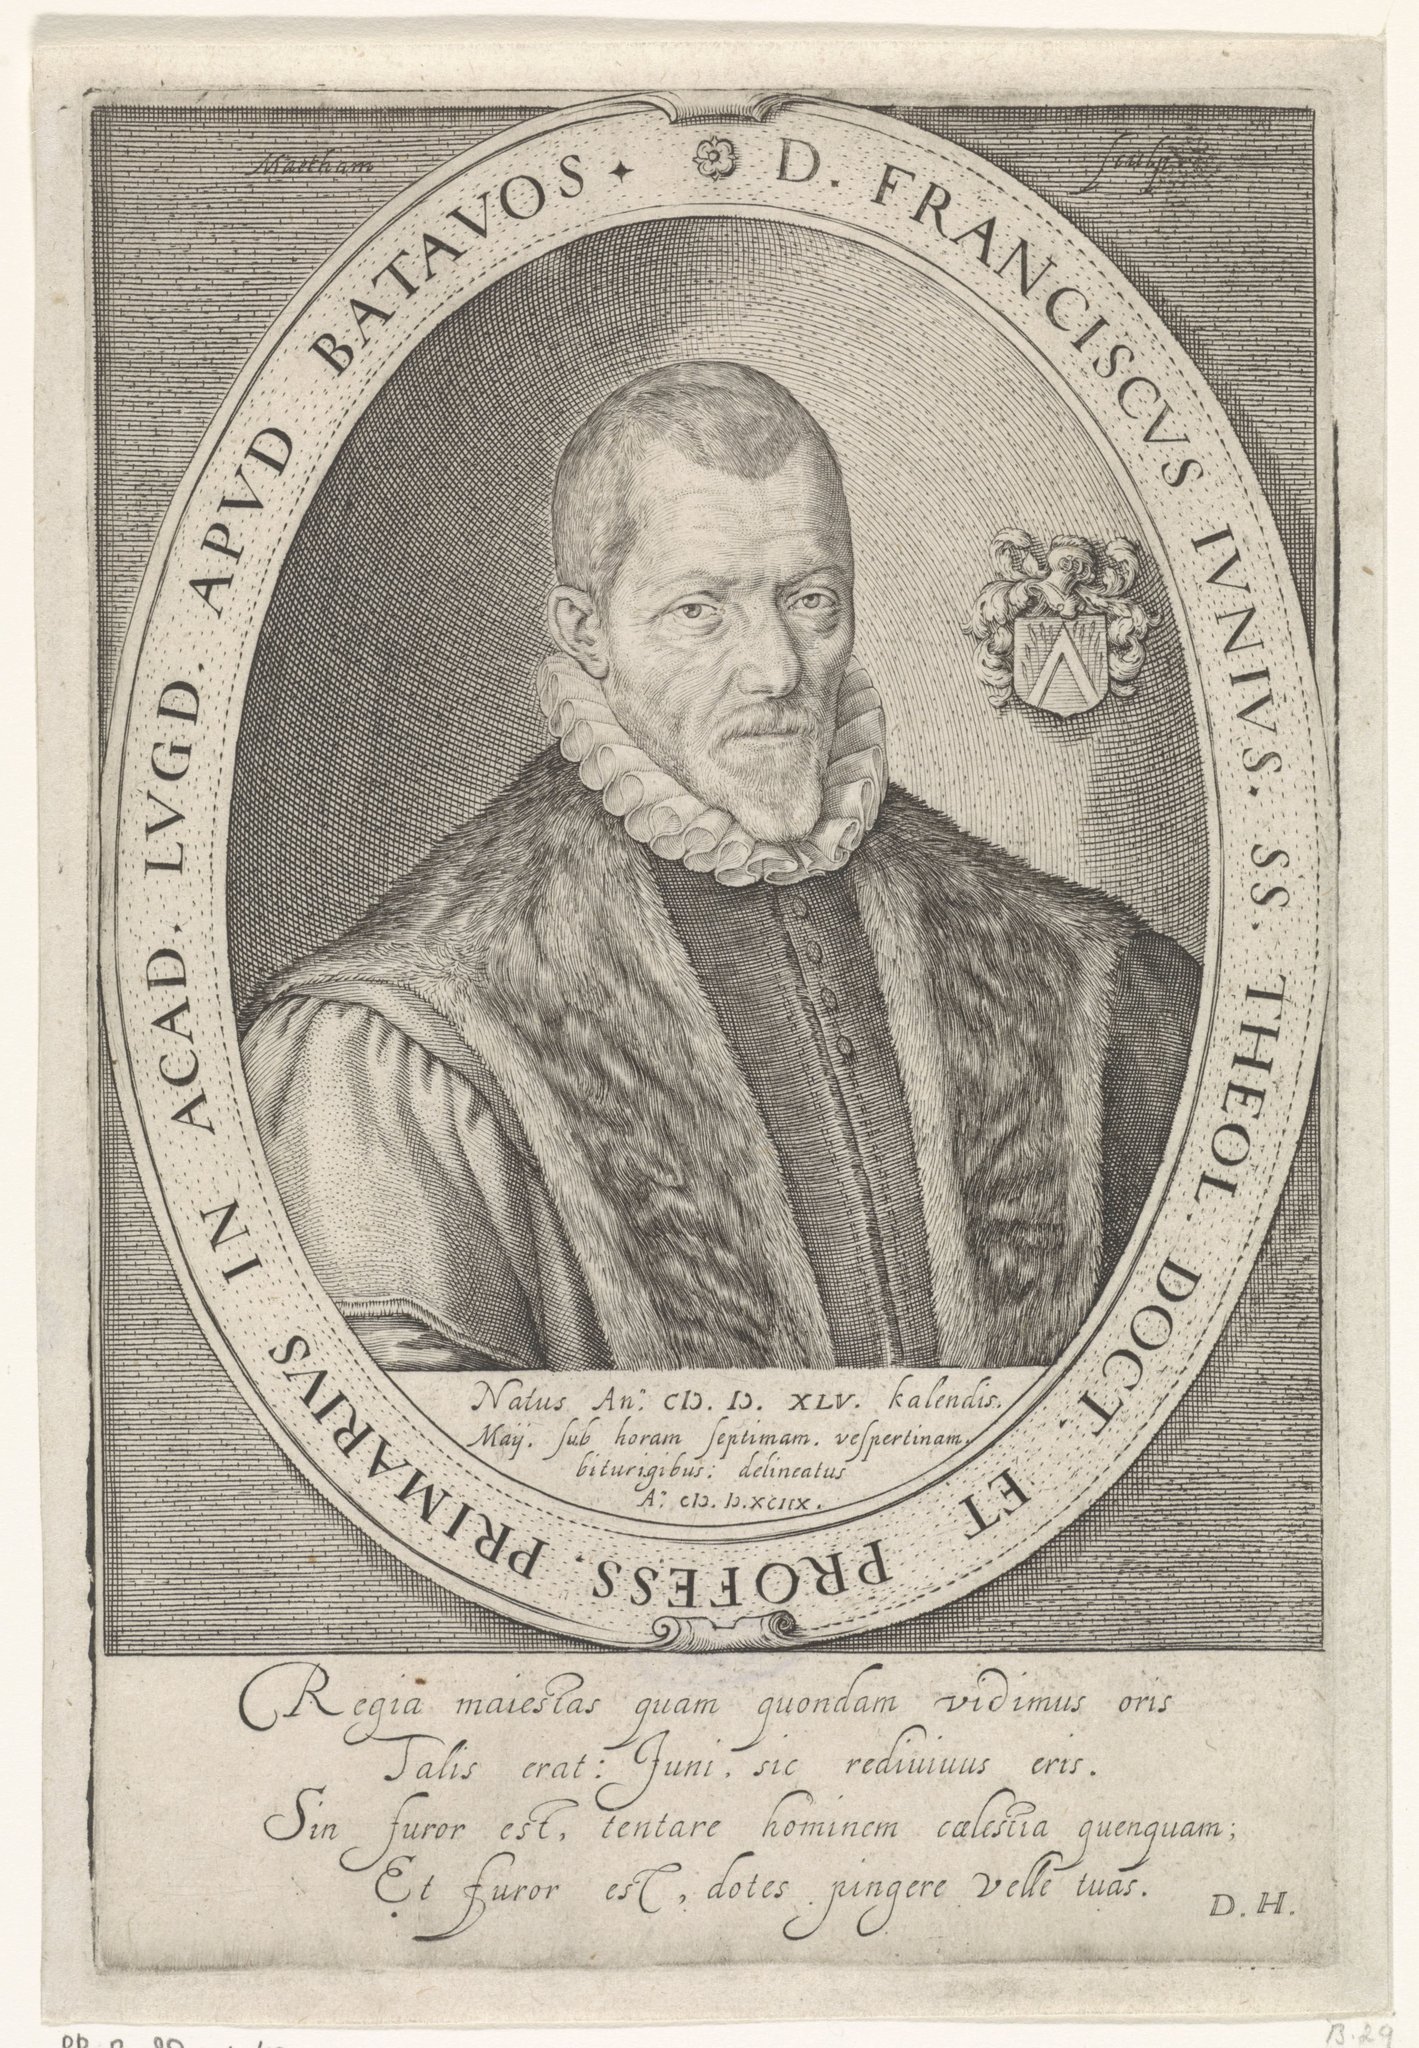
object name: print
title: Portret van Franciscus Junius II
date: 1598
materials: paper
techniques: engraving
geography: haarlem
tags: philology (+ portrait of scholar, scientist), historical persons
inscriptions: collector's mark: Lugt 2228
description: Portret van de taalgeleerde Franciscus Junius.